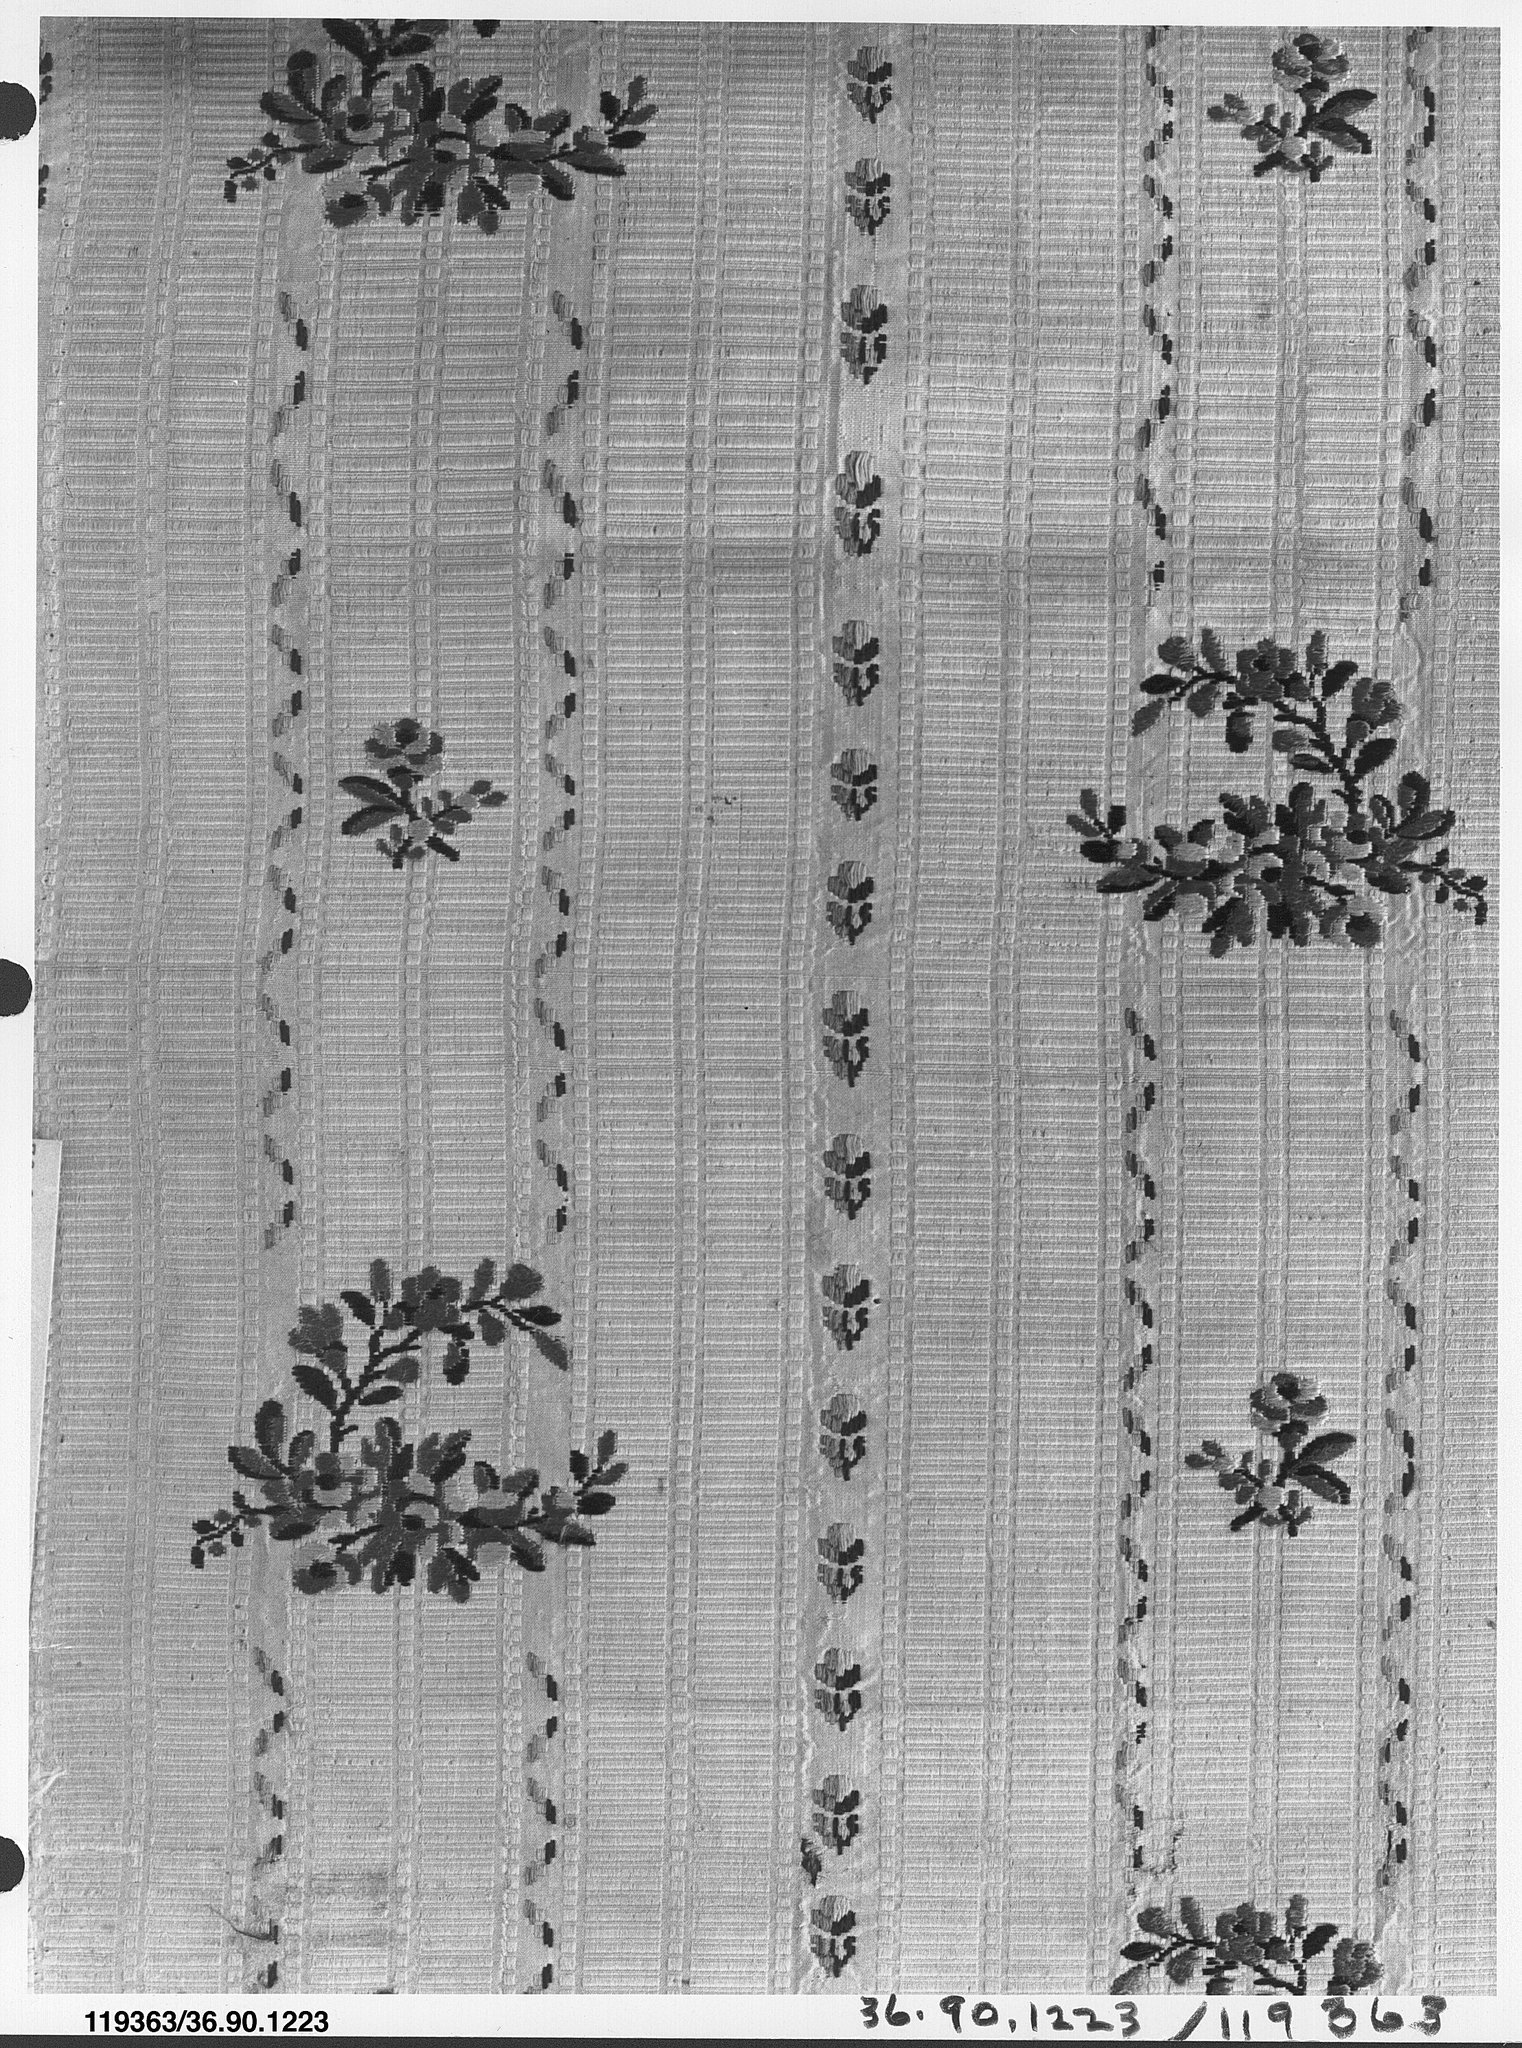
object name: piece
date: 1701-1800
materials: silk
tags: leaves